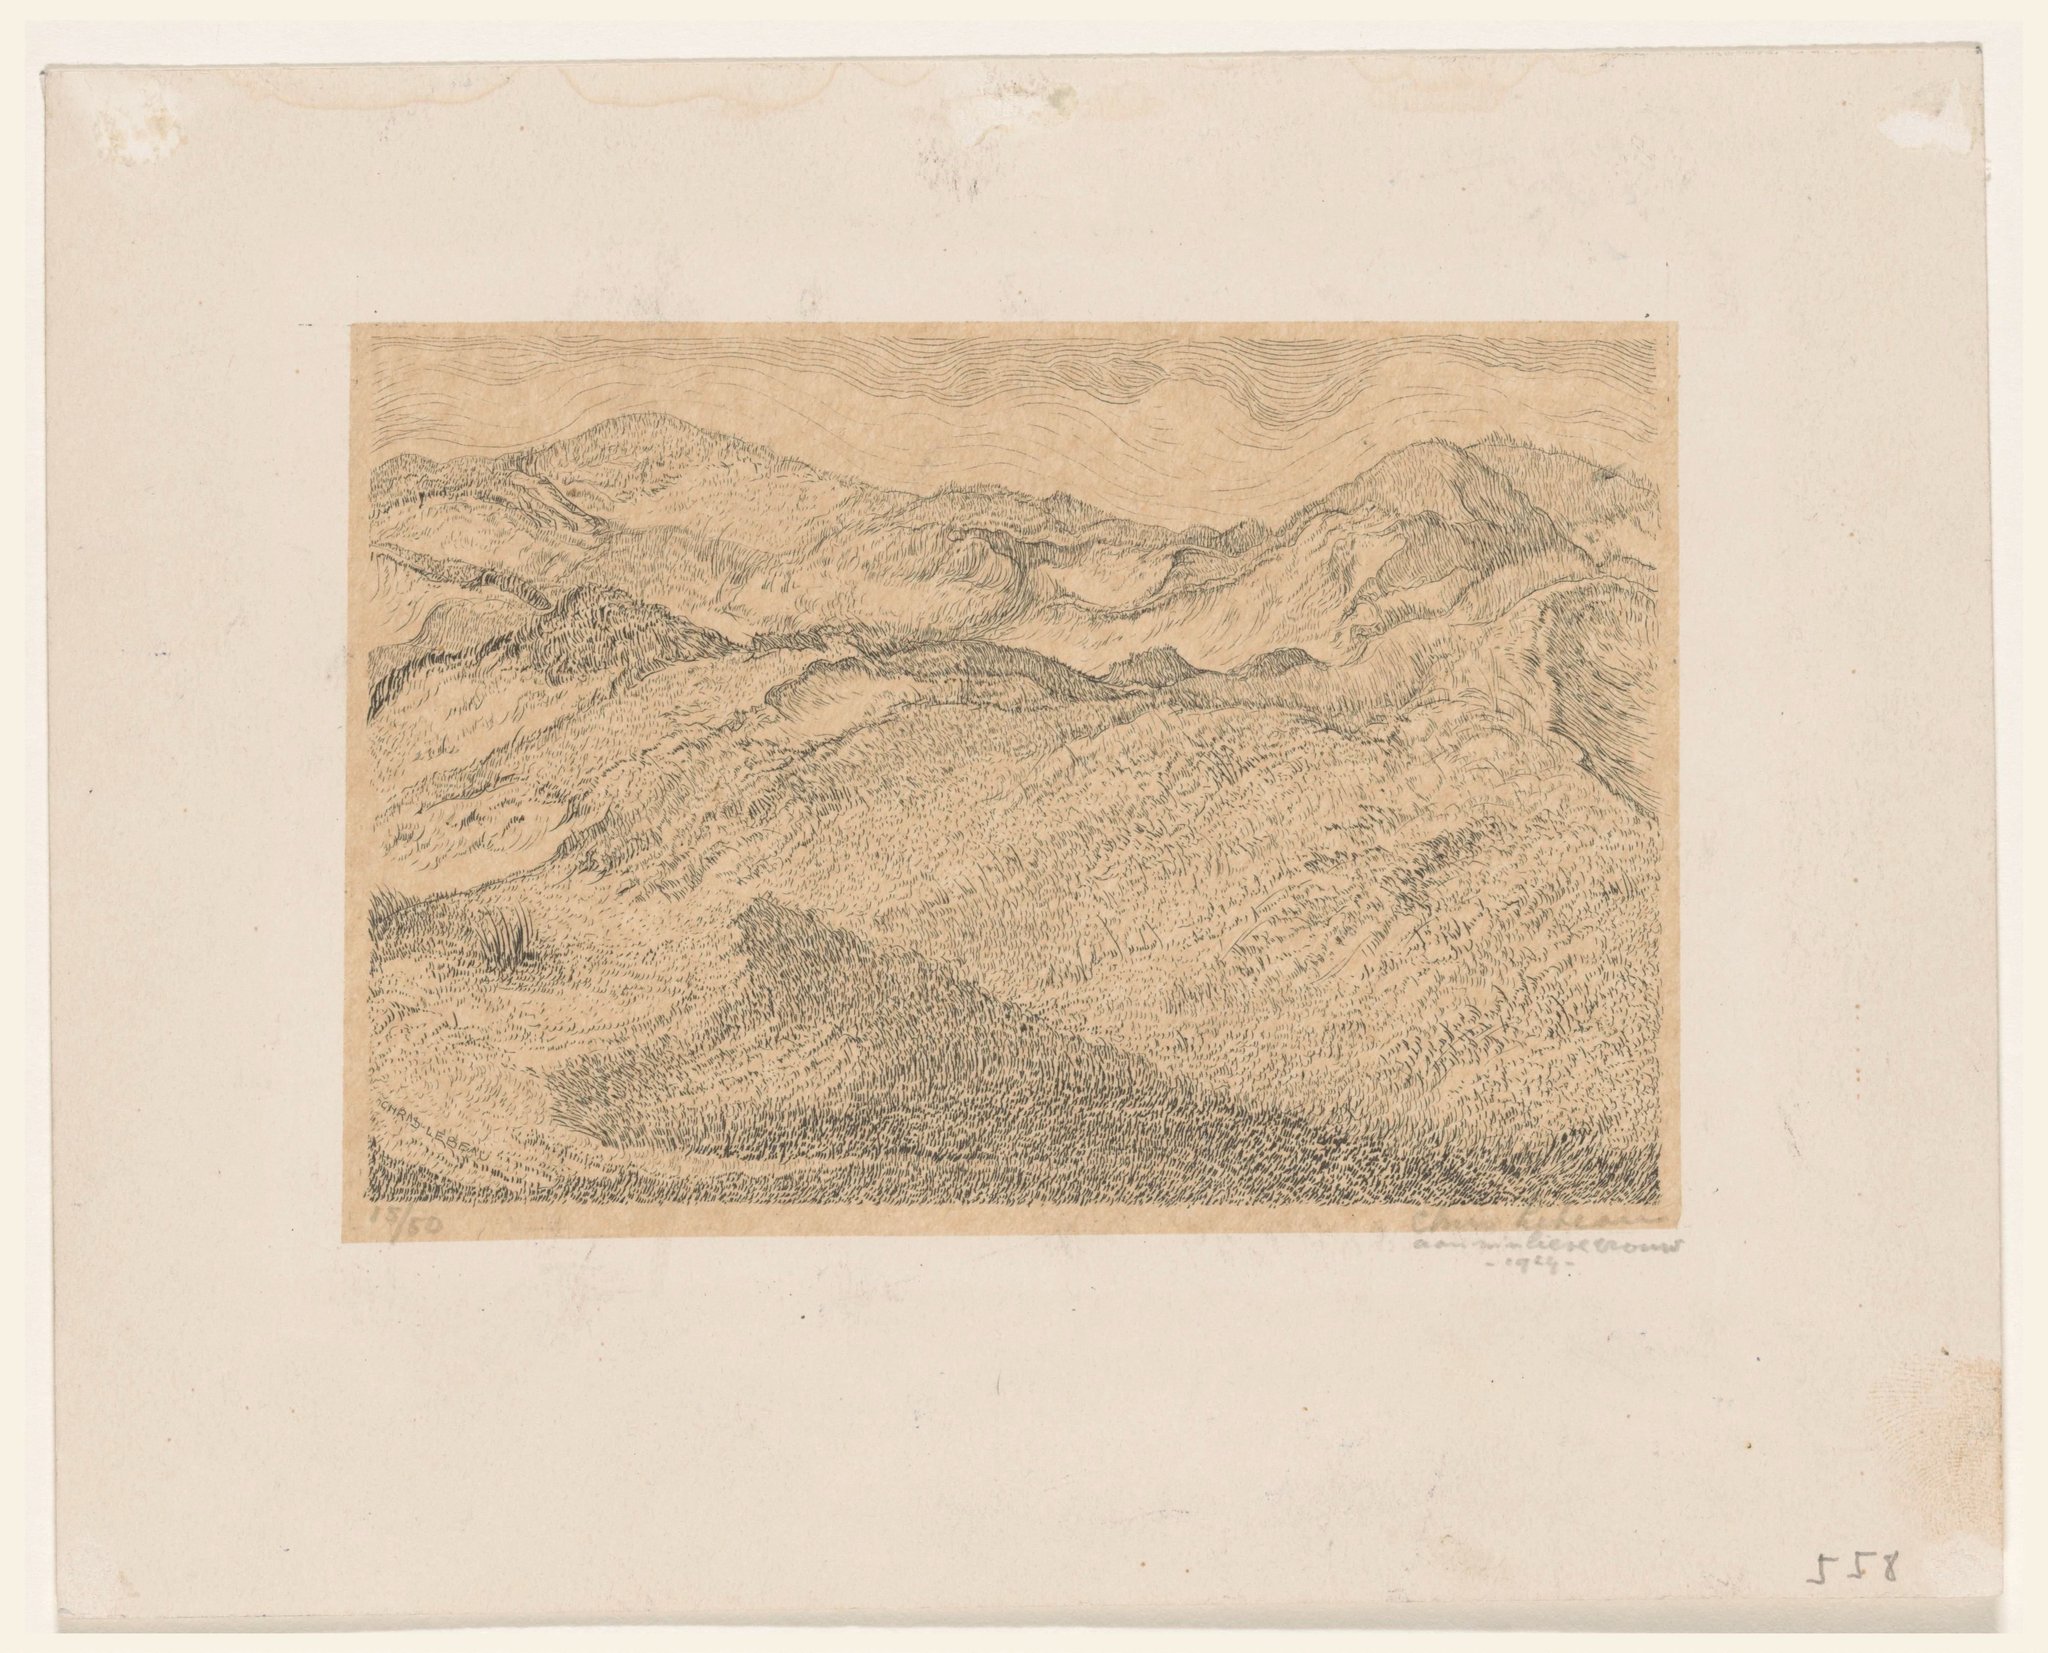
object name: print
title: Duinlandschap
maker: chris lebeau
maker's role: draughtsman, print maker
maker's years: 1878-1945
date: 1924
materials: paper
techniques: etching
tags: dunes (sea not visible); in the dunes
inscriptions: collector's mark: Lugt 2228, dedication: ‘aan m'n lieve vrouw’